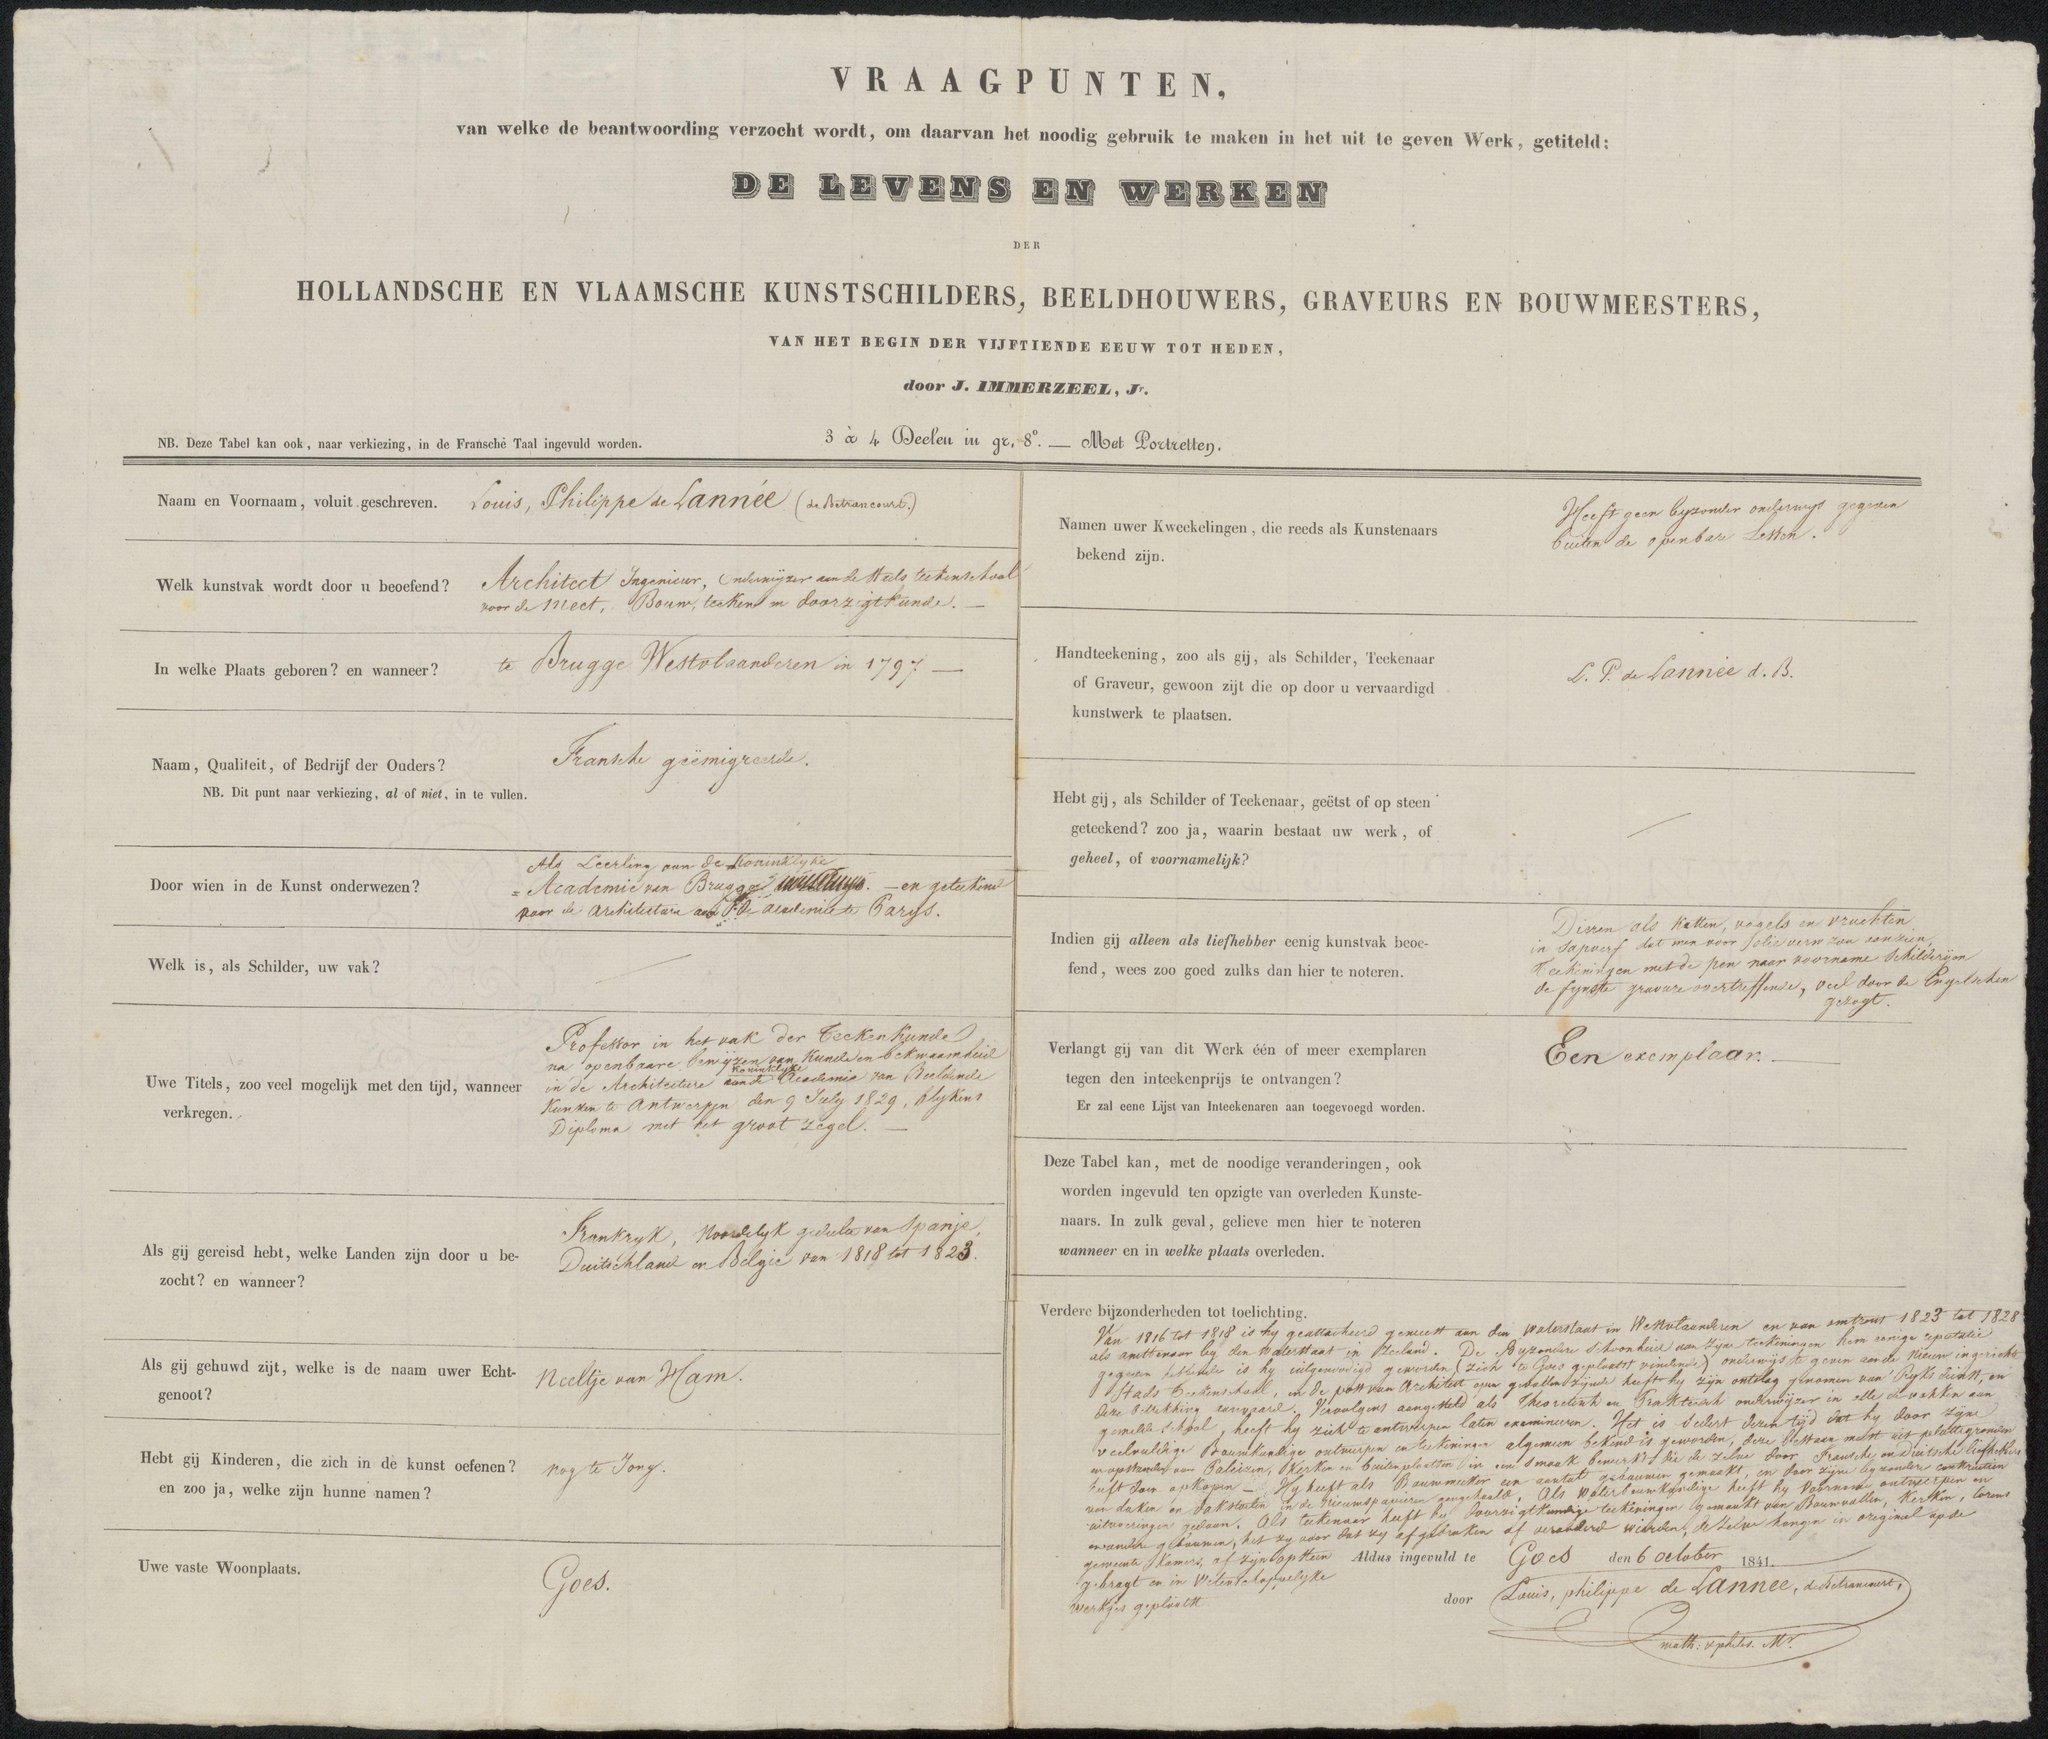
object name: questionnaire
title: Enquêteformulier ingevuld door Louis Philippe de Lannée de Betrancourt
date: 1841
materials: ink, paper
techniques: pen, printing, writing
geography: goes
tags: louis philippe de lannée de betrancourt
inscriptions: watermark, inscription: ‘Vraagpunten,/ van welke de beantwoording verzocht wordt, om daarvan het noodig gebruik te maken in het uit te geven Werk, getiteld: De levens en werken/ der Hollandsche en Vlaamsche kunstschilders, beeldhouwers,/ graveurs en bouwmeesters, van het begin der vijftiende eeuw tot heden/ door J. Immerzeel, Jr.’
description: Opgenomen in: Immerzeel, J. Jr., De levens en werken der Hollandsche en Vlaamsche kunstschilders, beeldhouwers, graveurs en bouwmeesters, van het begin der vijftiende eeuw tot heden, Amsterdam: J.C. van Kesteren, 1842-1843.